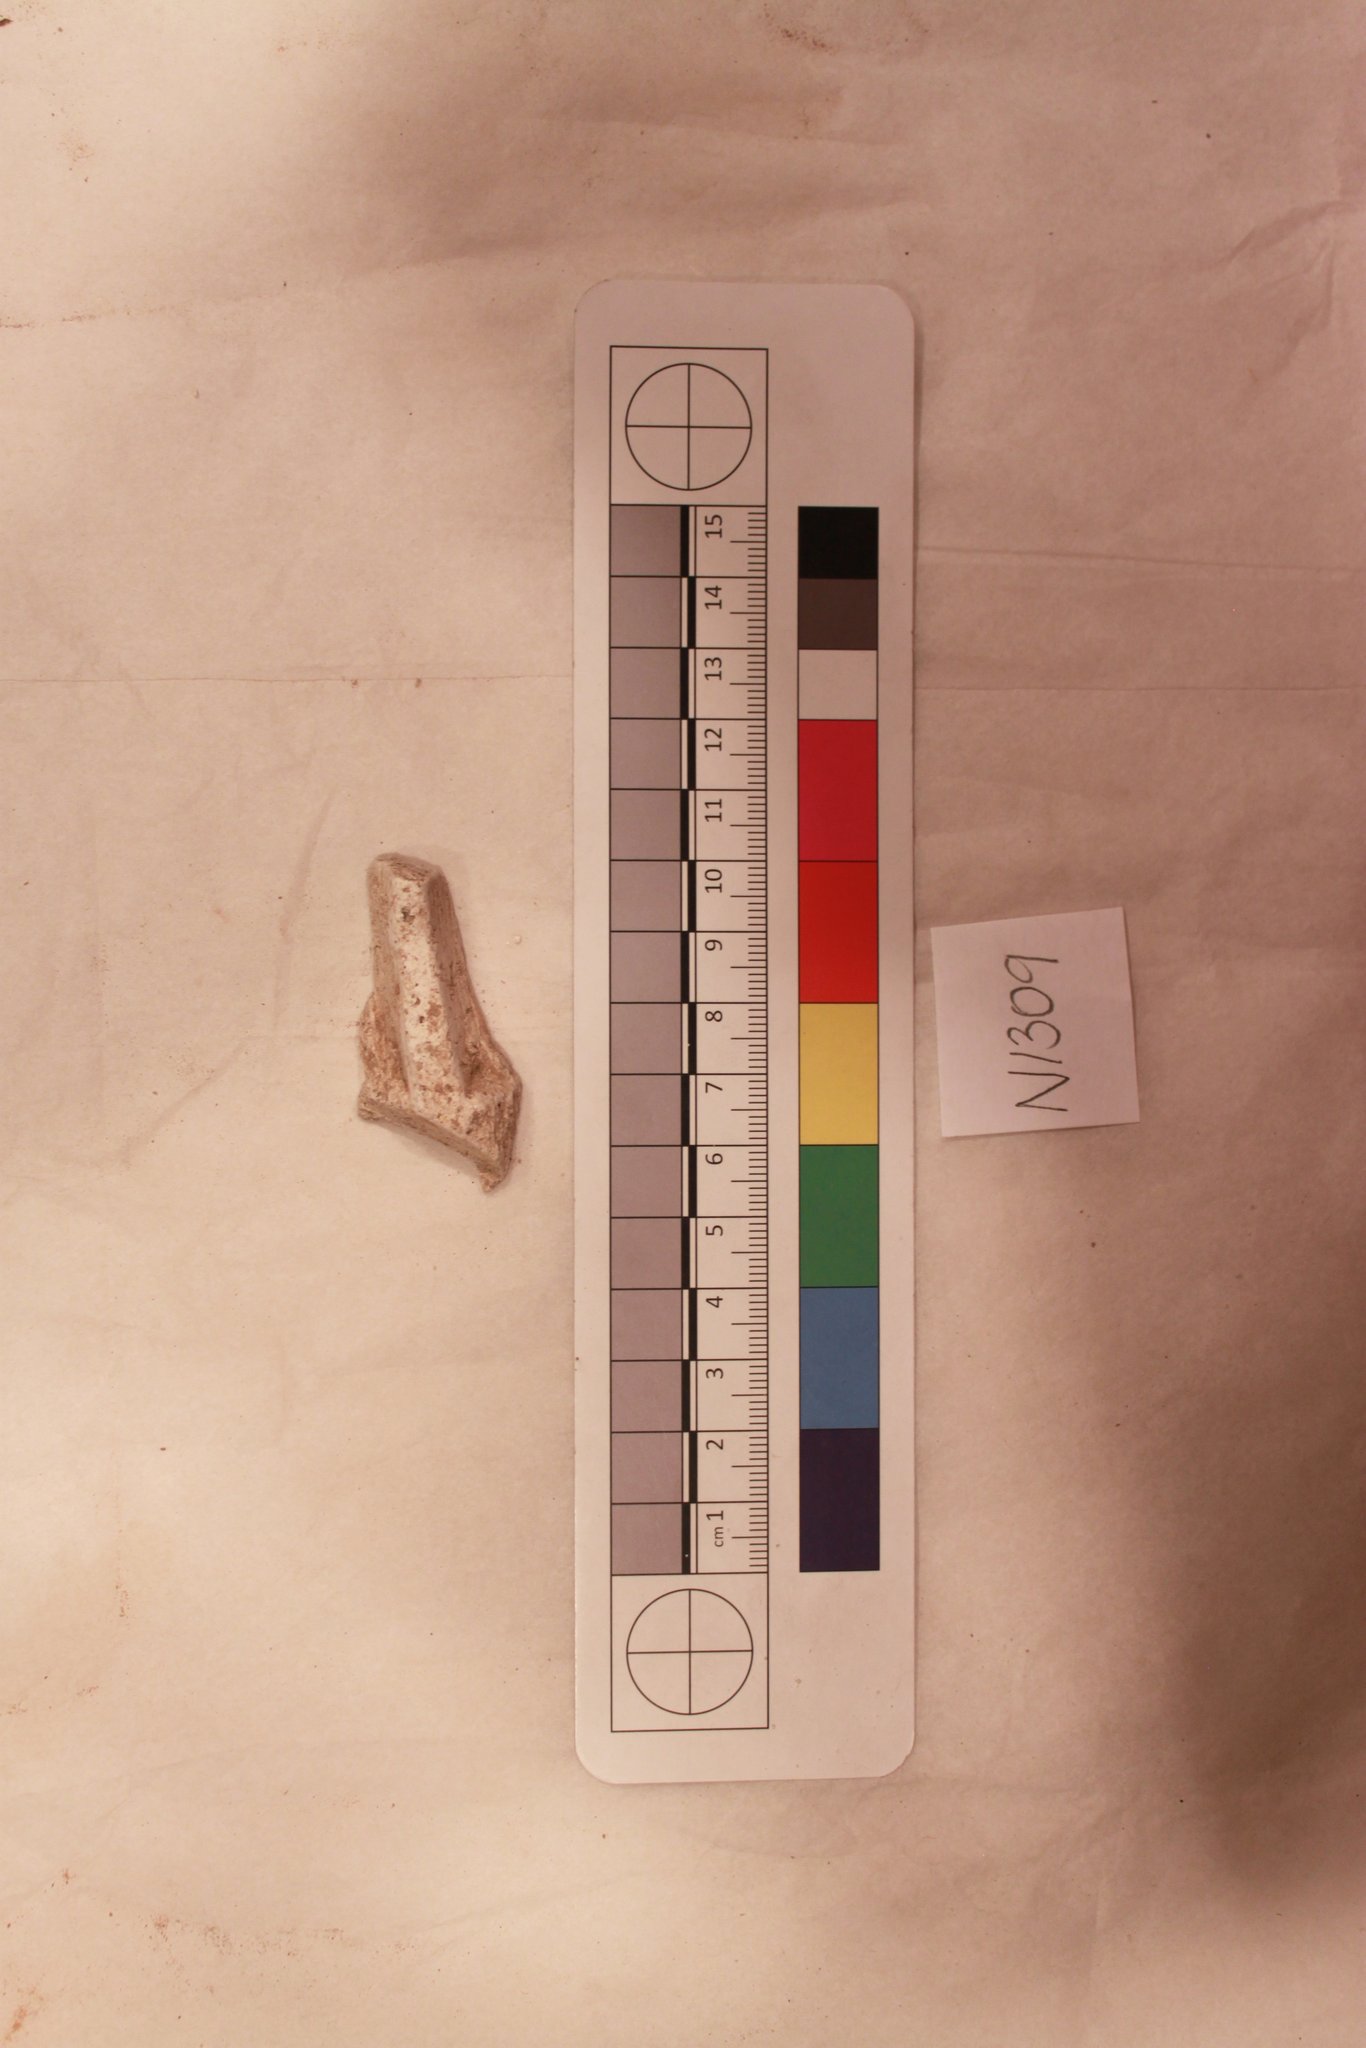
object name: fragment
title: Stucco Fragment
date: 701-1200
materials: plaster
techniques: carving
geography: iran